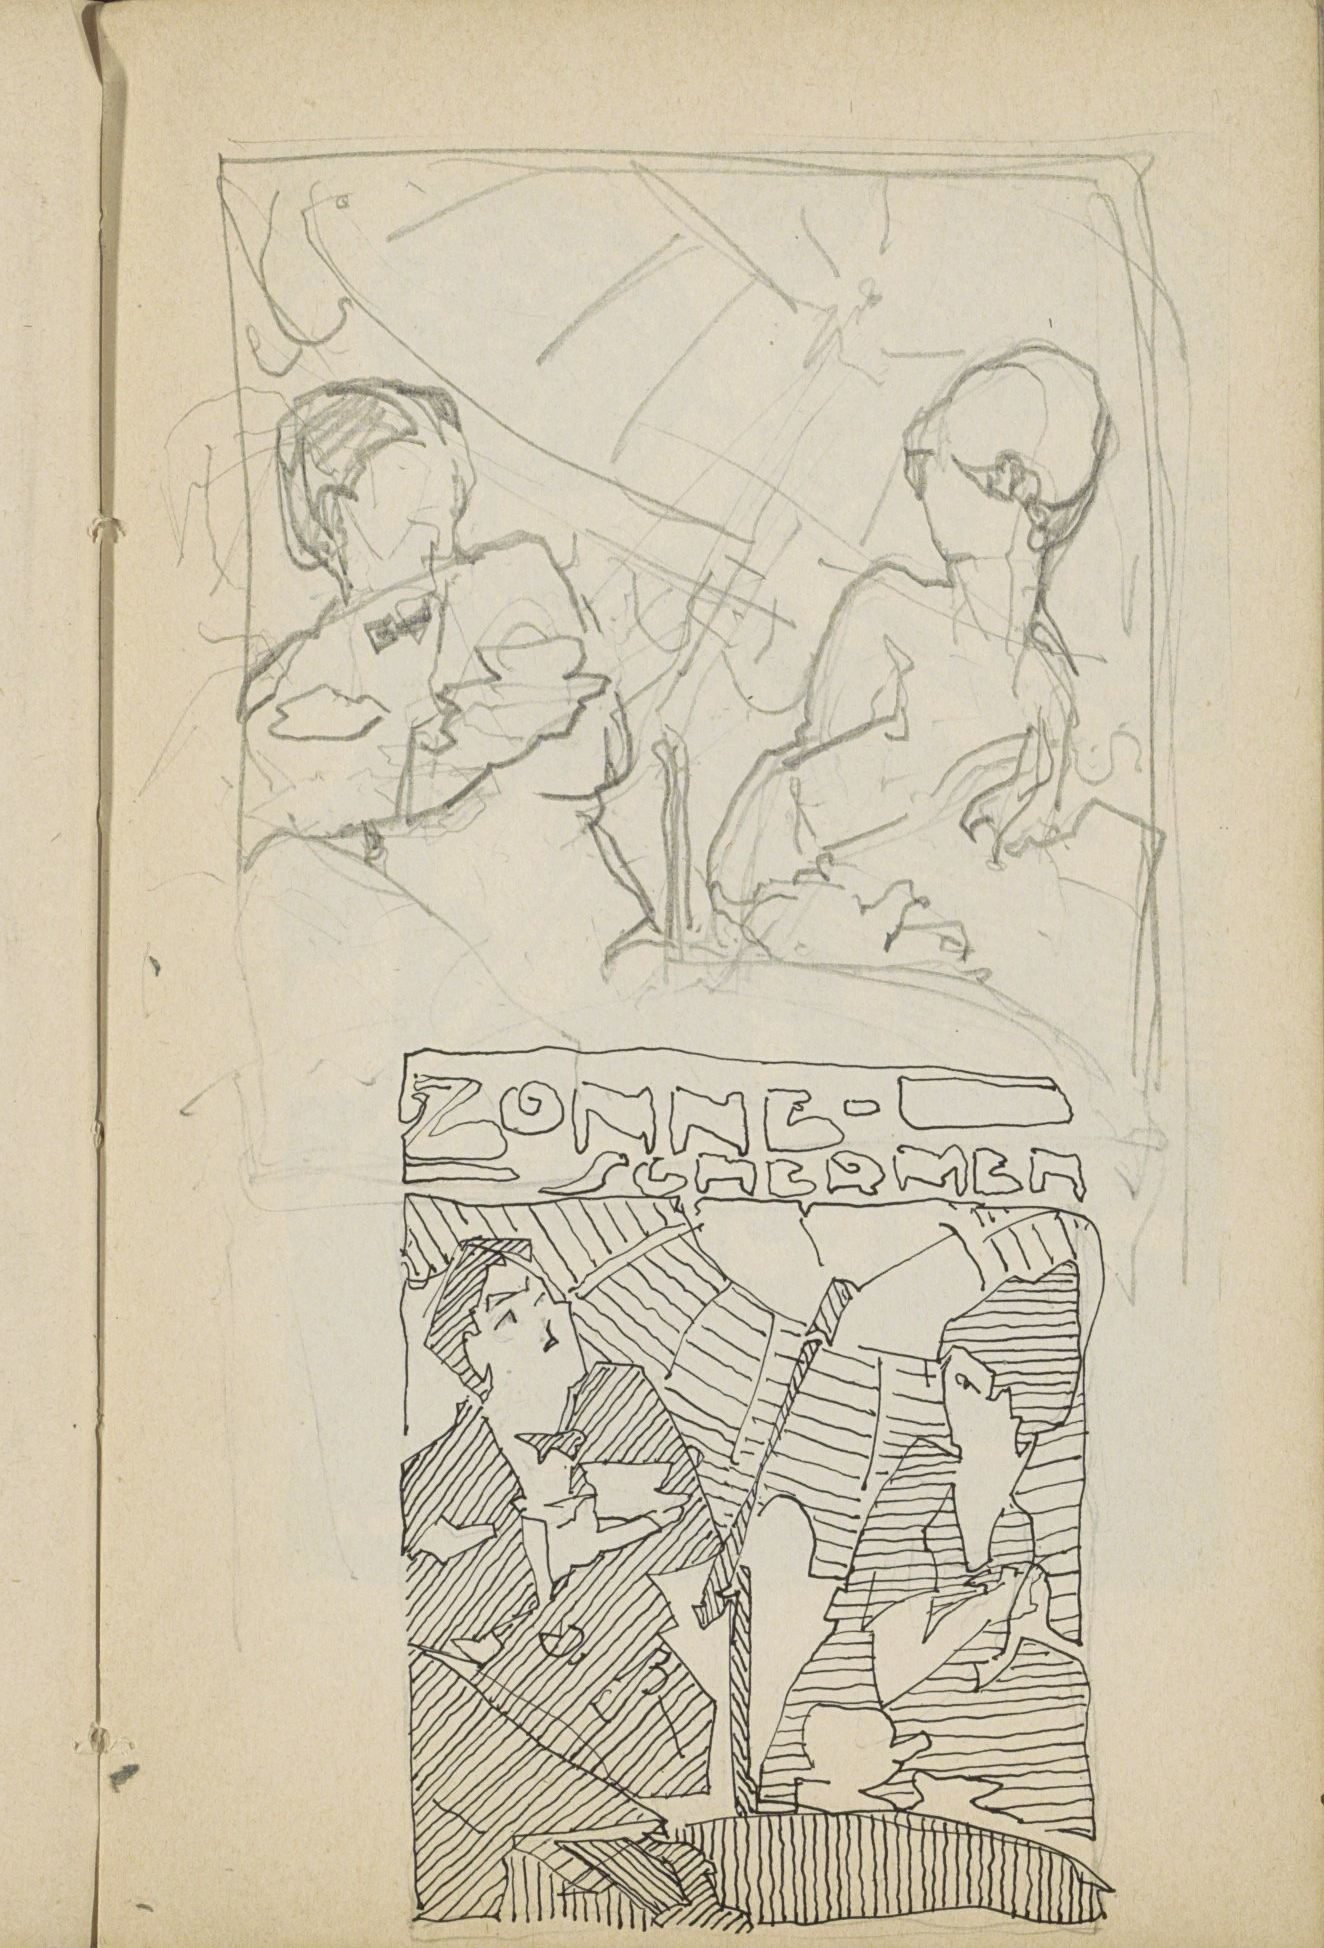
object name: sketchbook leaf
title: Reclameontwerp voor zonneschermen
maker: reijer stolk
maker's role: draughtsman, print maker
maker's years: 1896-1945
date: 1908-1919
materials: ink, paper, pencil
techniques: pen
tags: sitting figure, advertising, parasol, sunshade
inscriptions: annotation: ‘ZONNE-/ SCHERMEN’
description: Het ontwerp toont een man en vrouw zittend onder een parasol. Blad 8 recto uit een schetsboek met 33 bladen.